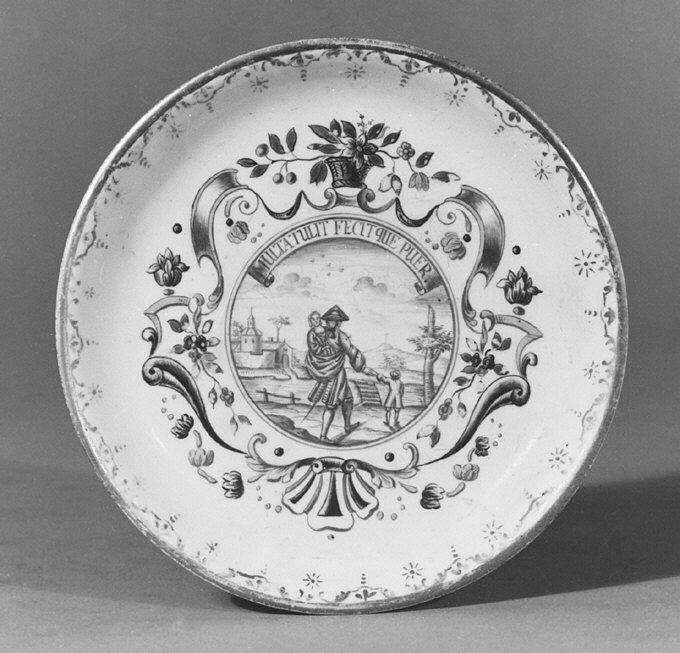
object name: saucer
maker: meissen manufactory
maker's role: manufactory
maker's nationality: german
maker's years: 1710-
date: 1744-1748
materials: hard paste porcelain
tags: houses,boys,men,trees